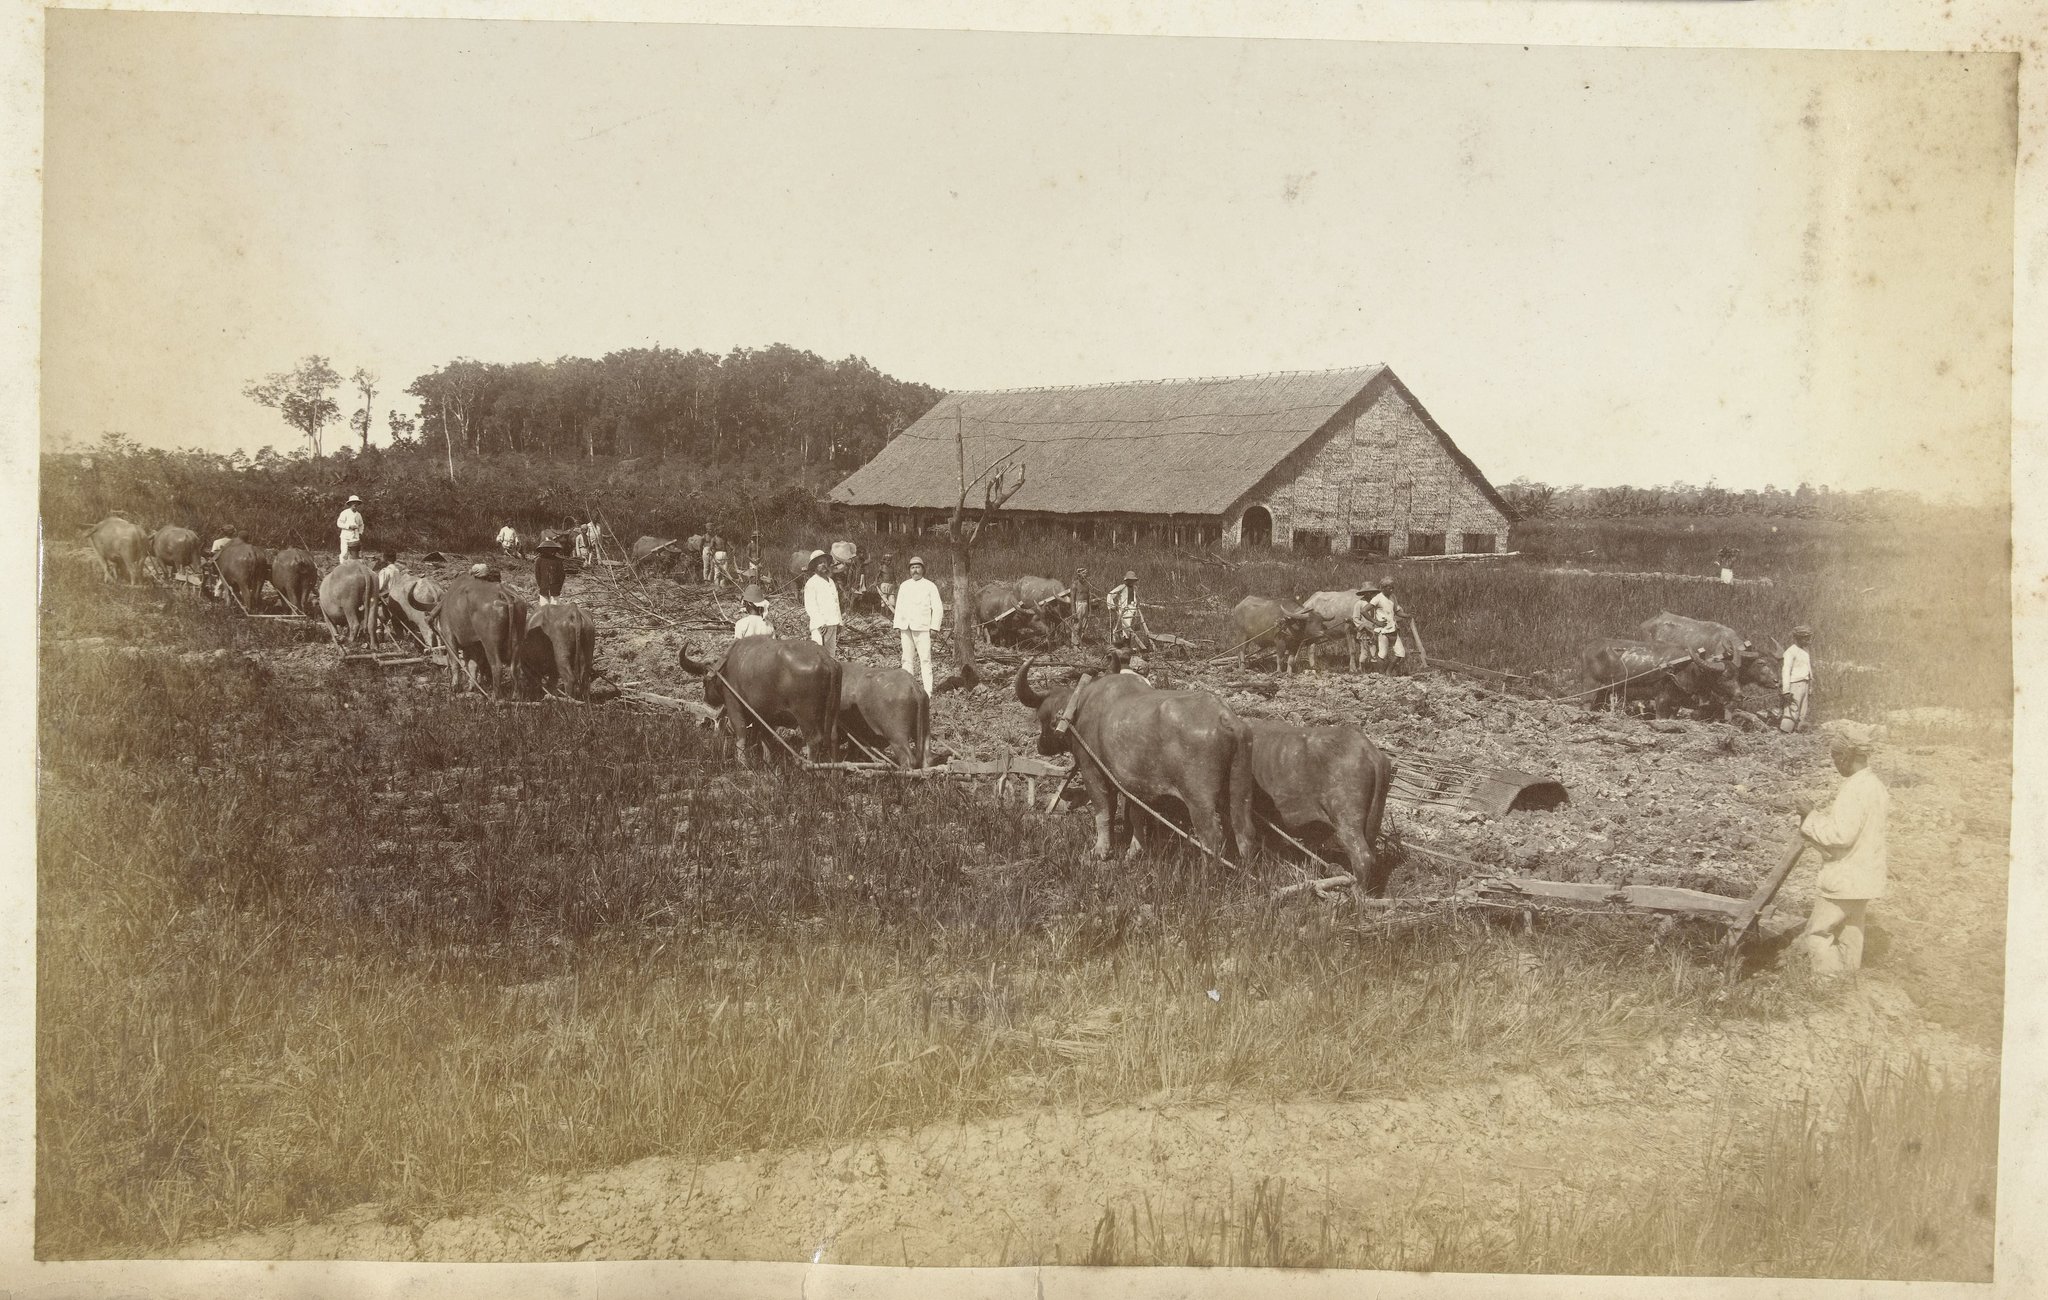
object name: photograph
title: Ploegen voortgetrokken door runderen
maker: Anonymous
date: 1890-1910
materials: cardboard, paper, photographic support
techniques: gelatin silver print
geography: surabaya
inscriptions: caption: ‘Ploegen in Deli. Systeem Macdonald’